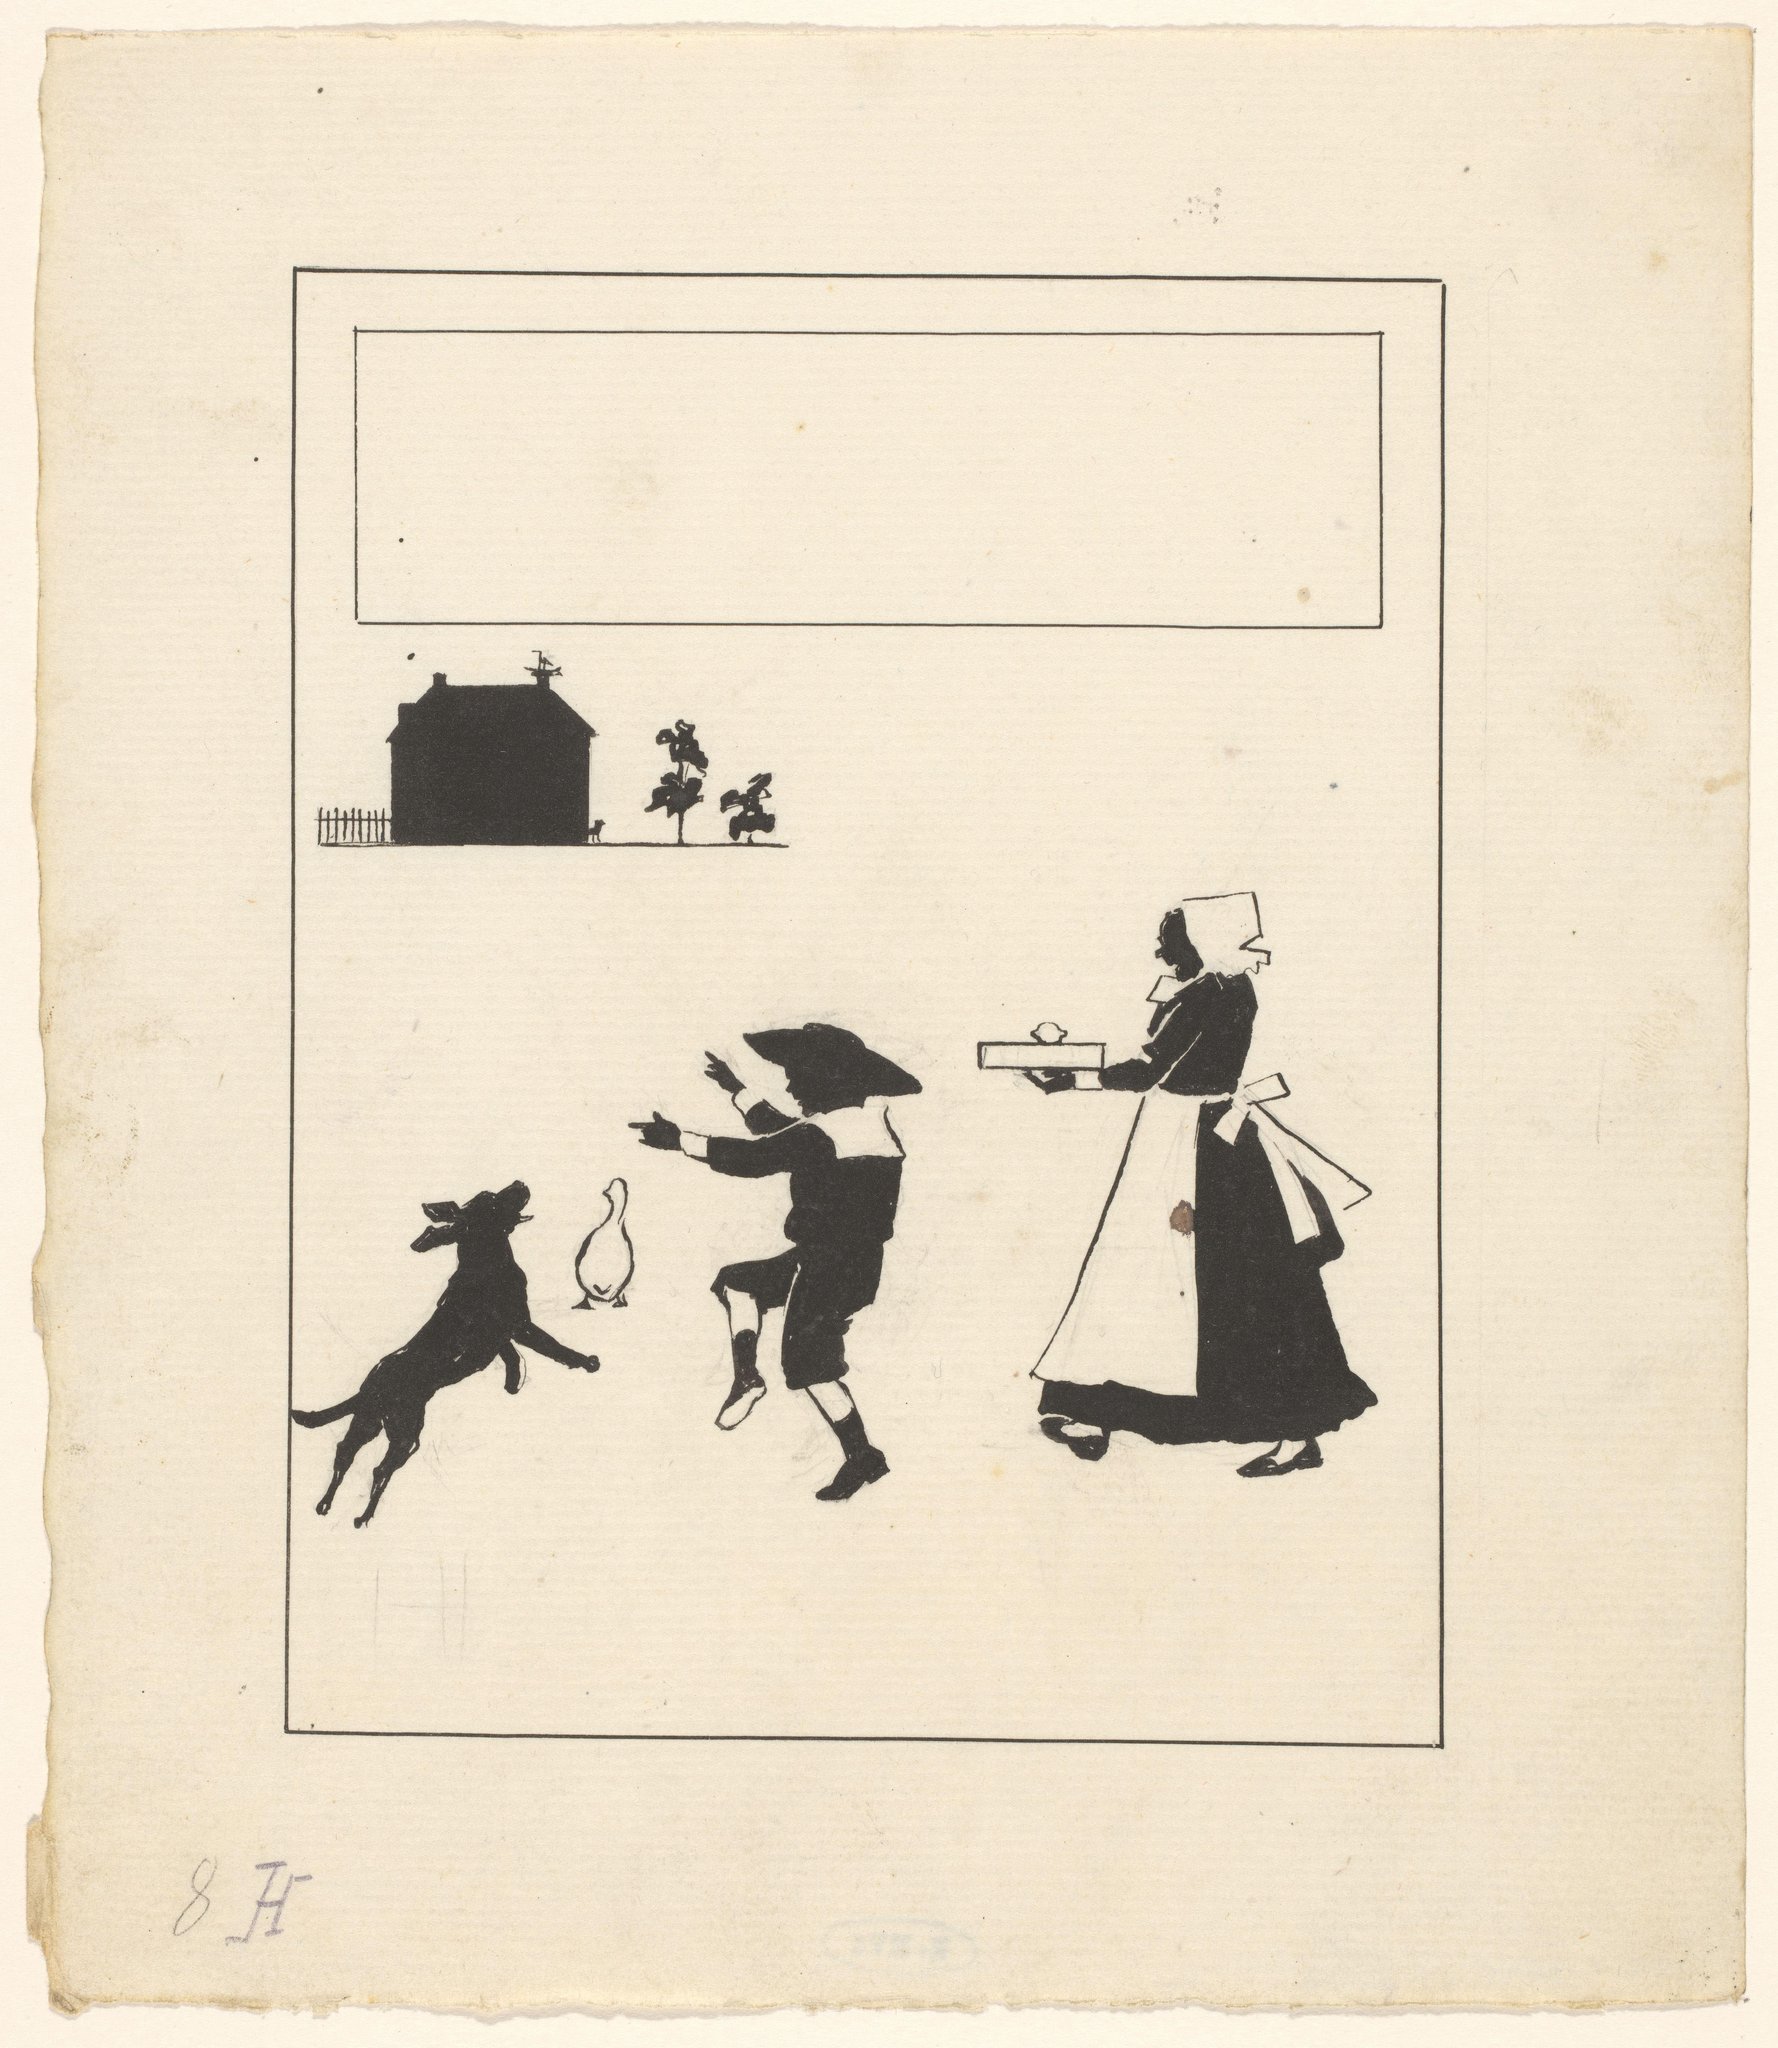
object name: drawing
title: Groep mensen en dieren loopt richting een huis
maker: Anonymous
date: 1880-1910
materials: ink, paper, pencil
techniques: brush, pen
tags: boy (child between toddler and youth), farm or solitary house in landscape, dog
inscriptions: watermark:, number: ‘8 H’, collector's mark: Lugt 2228a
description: Een groep bestaande uit een jongen, hond, gans en een vrouw met een doos en stuk fruit lopen richting een huis in de verte.